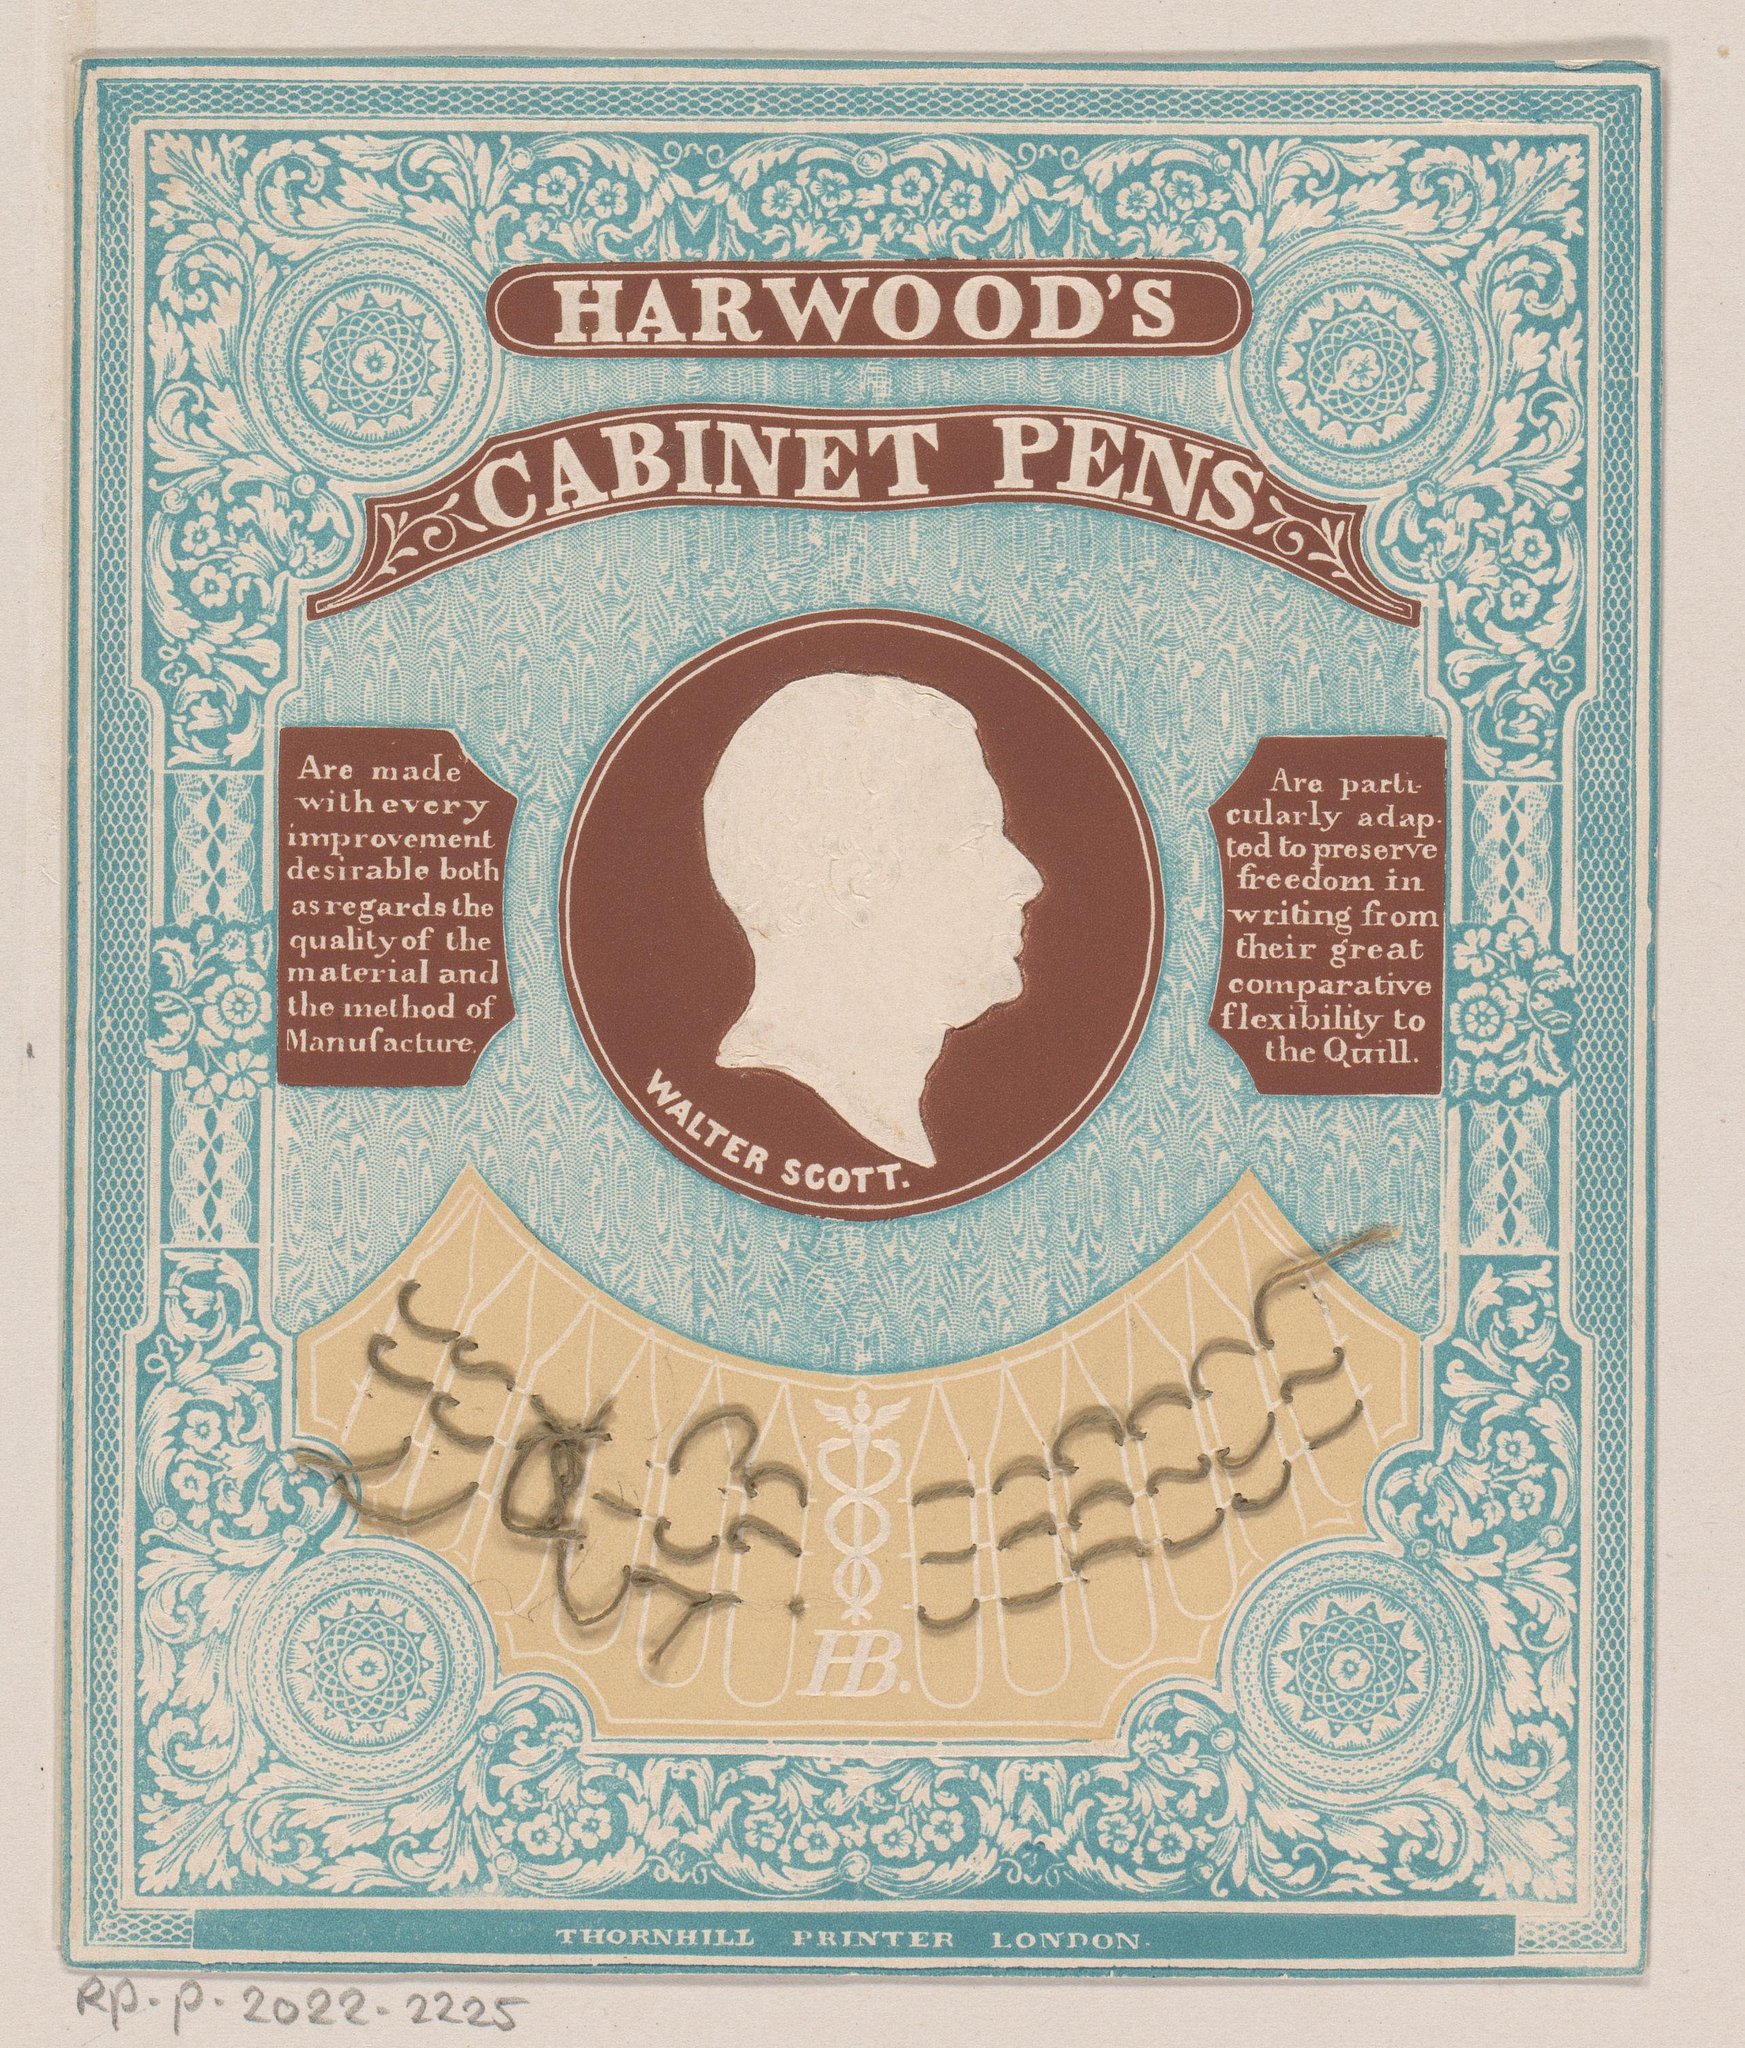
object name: advertisement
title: Advertentie van Harwood's Cabinet Pens te Londen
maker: Anonymous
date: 1830-1844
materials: paper, fiber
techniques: relief print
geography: london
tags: advertisement, notice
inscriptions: inscription: ‘F[E?] 1.20’